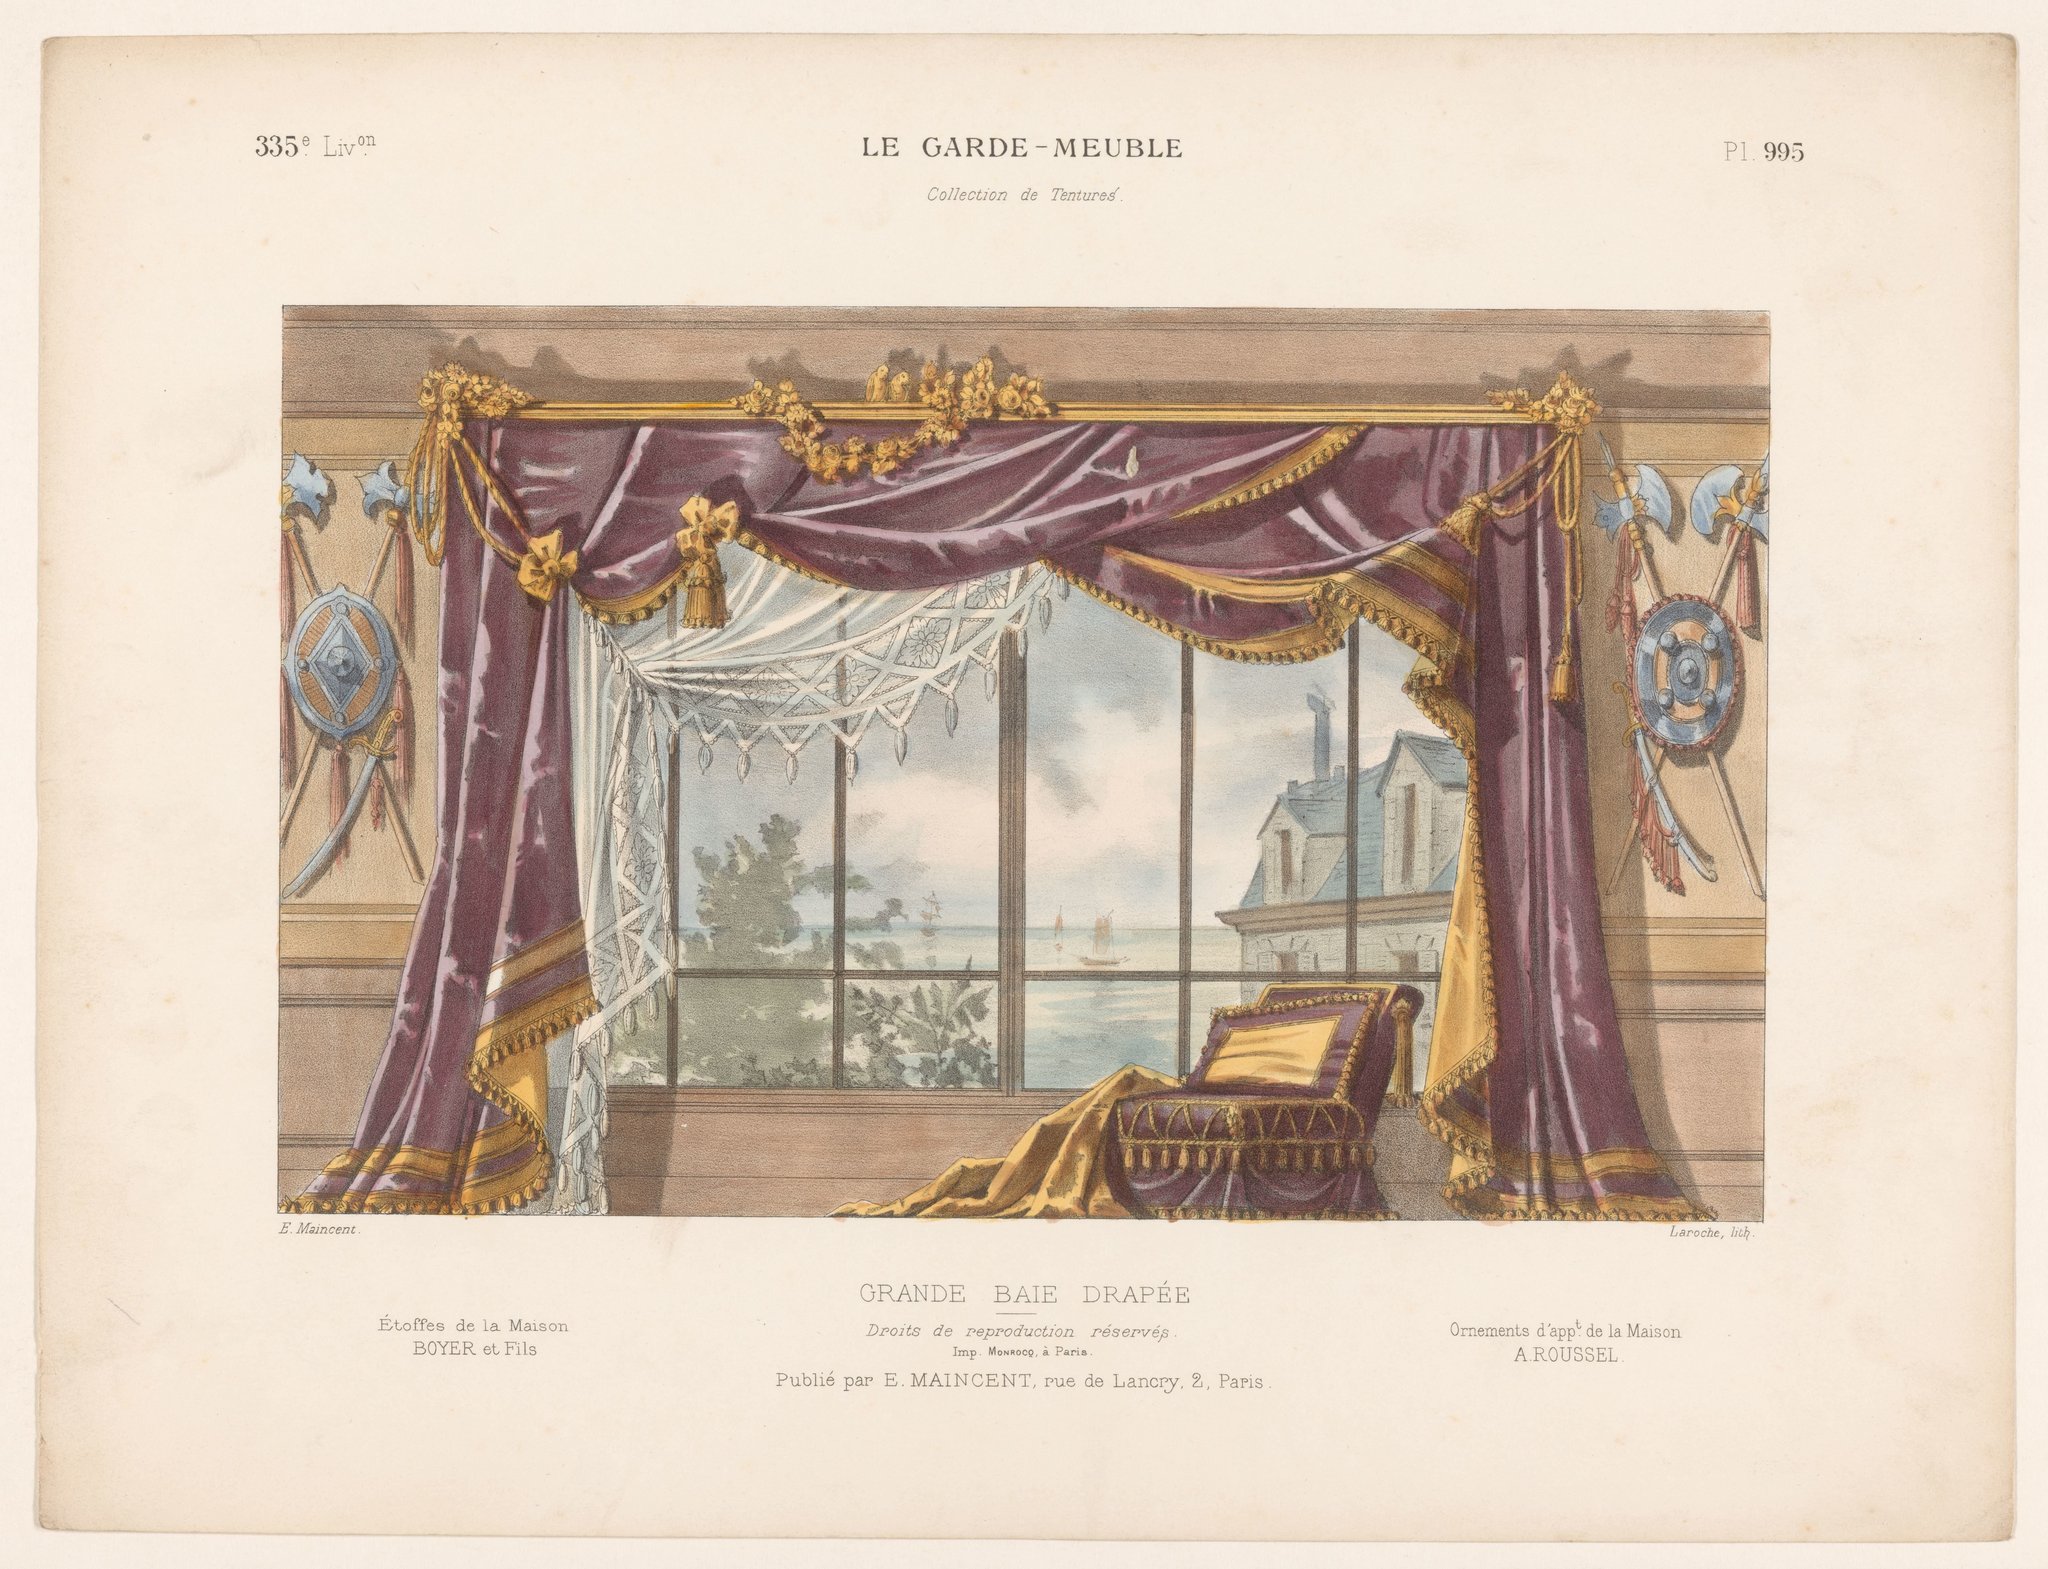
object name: print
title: Doorgang met gordijnen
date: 1885-1895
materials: paper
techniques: hand coloring, lithograph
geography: paris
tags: decorations (interior of the house), door, hangings and drapery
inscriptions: : ‘Droits de reproduction réservés.’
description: Grote doorgang met fauteuil en gedrapeerde gordijnen. Prent uit 335e Livraison.